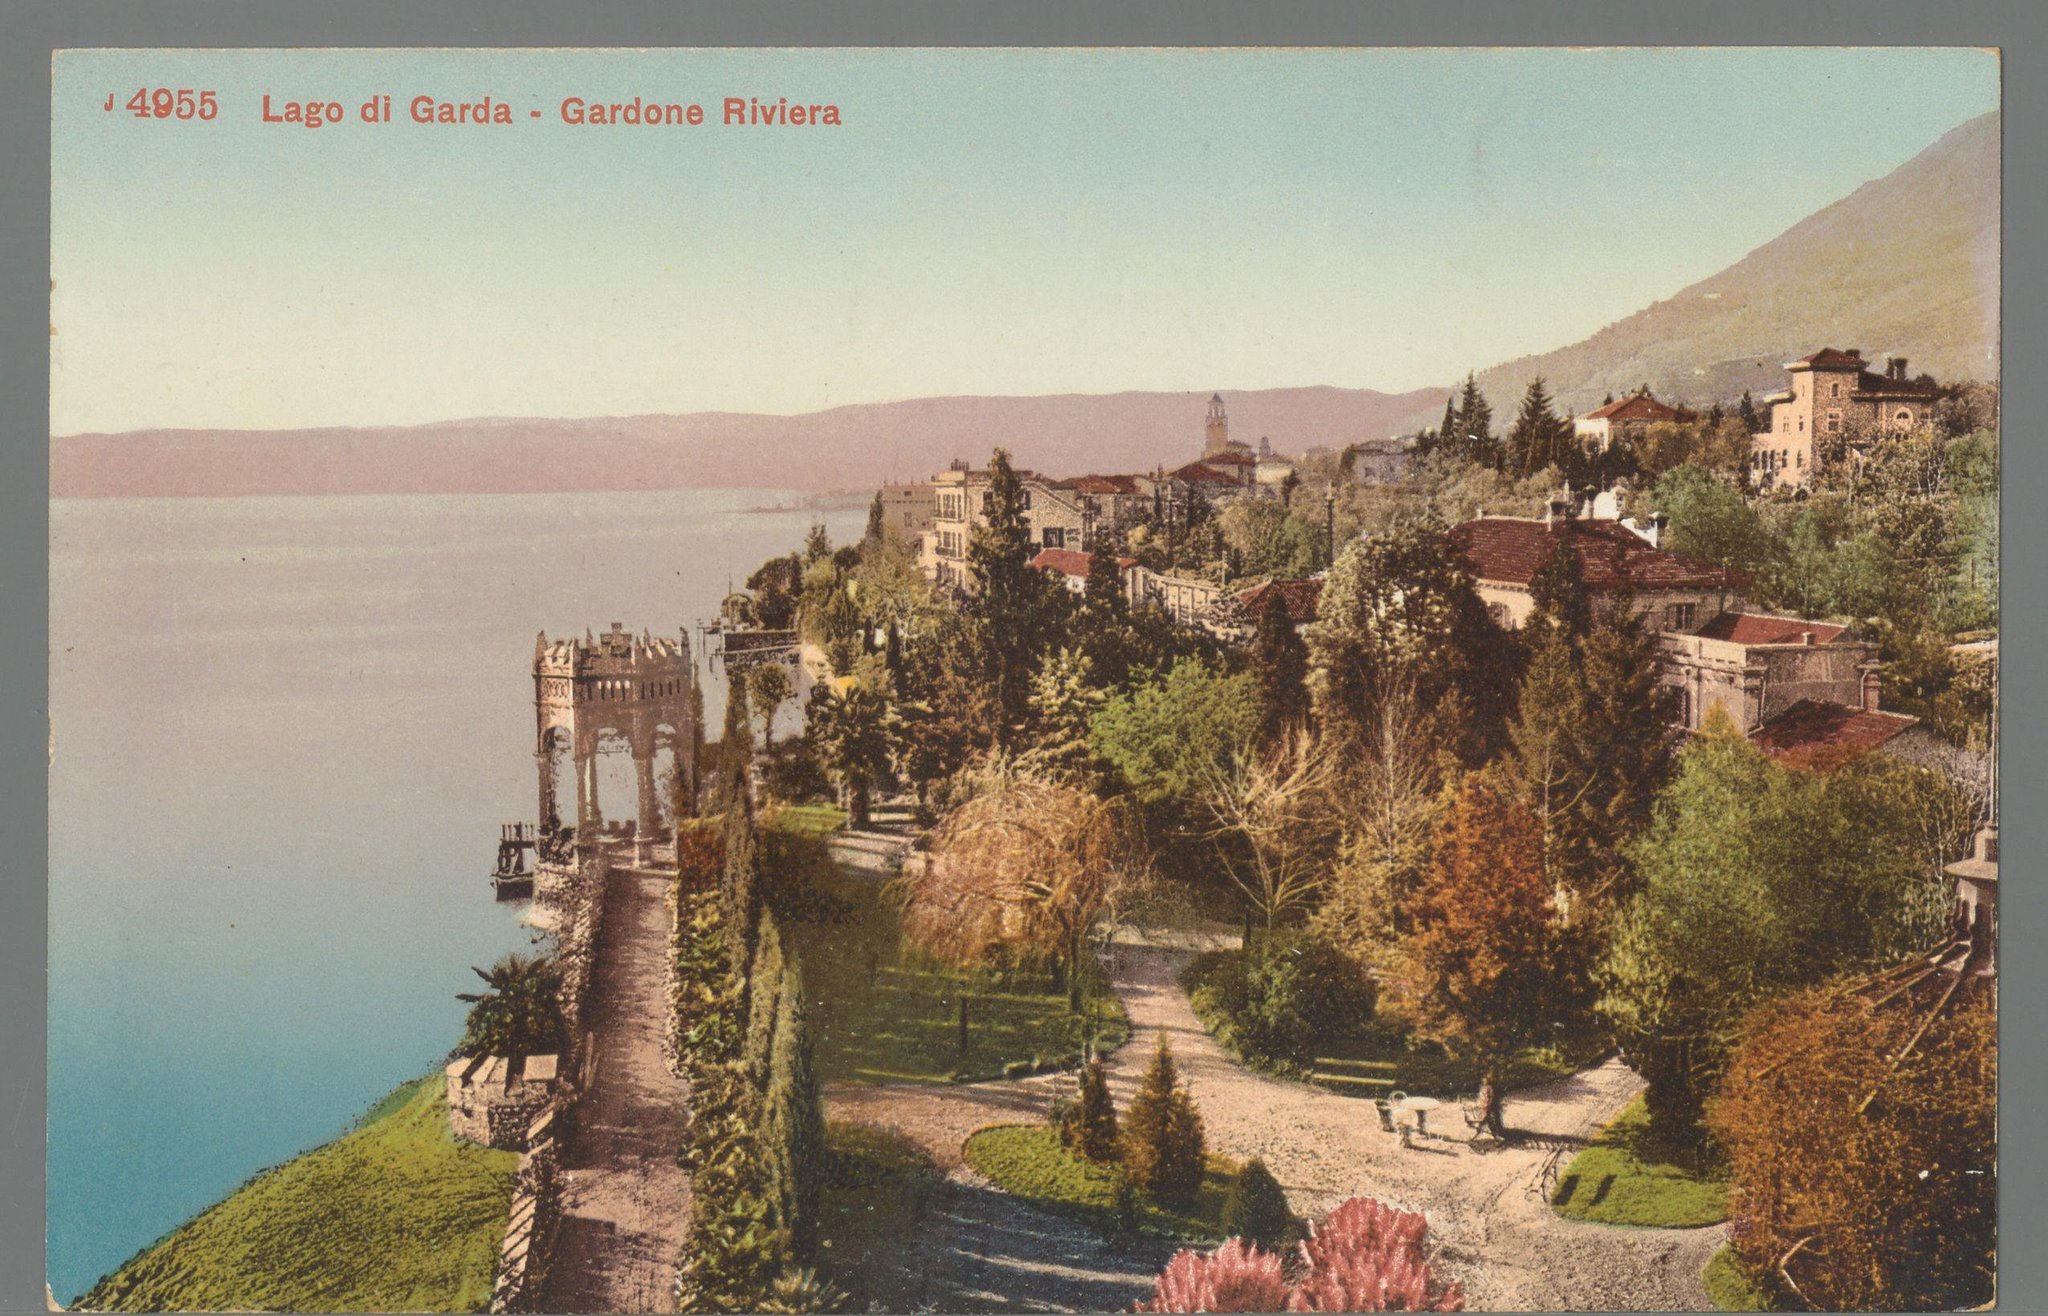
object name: photomechanical print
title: Lago di Garda. Gardone Riviera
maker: Anonymous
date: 1905-1930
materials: cardboard, photographic process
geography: zurich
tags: prospect of village, silhouette of village, lake, mountains